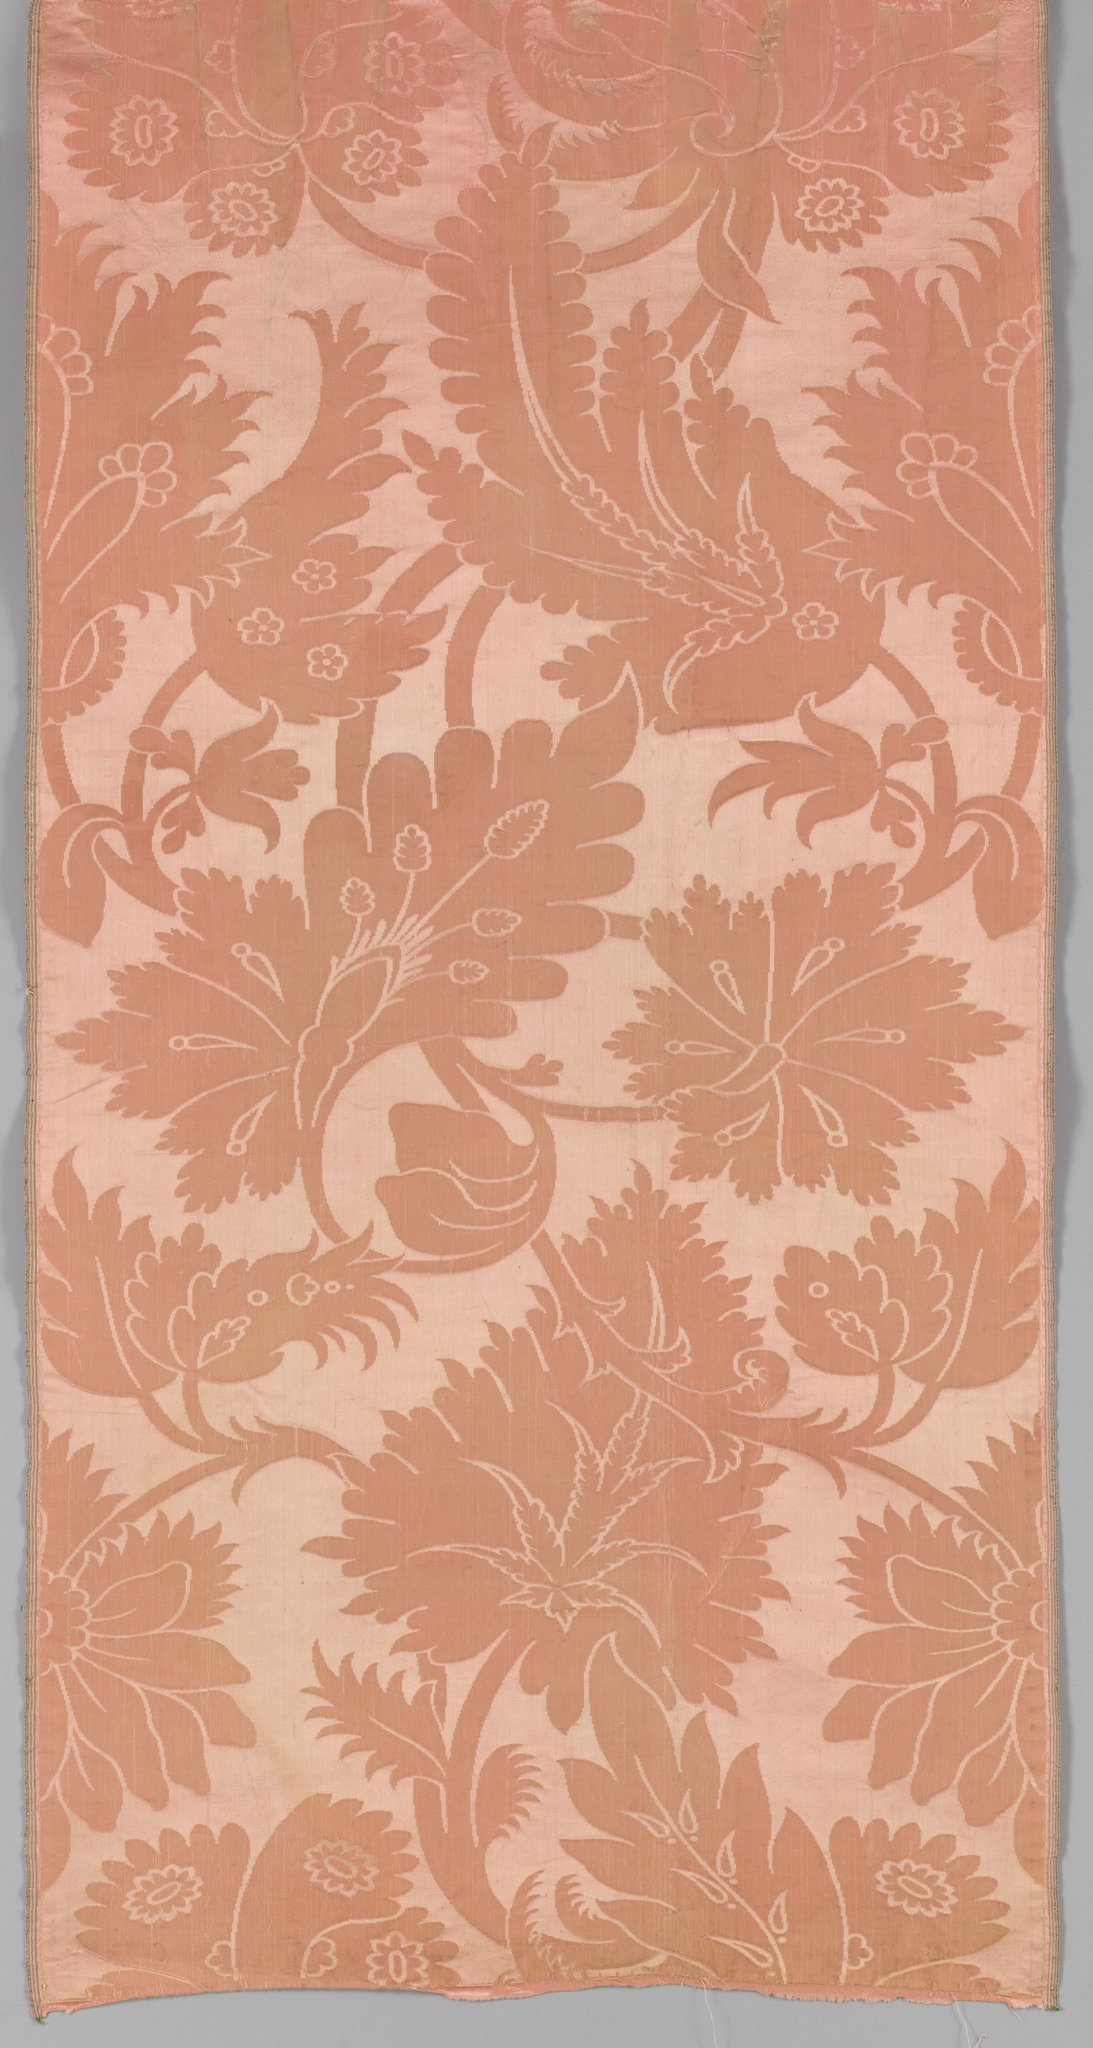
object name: skirt panel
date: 1740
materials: silk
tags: flowers,leaves